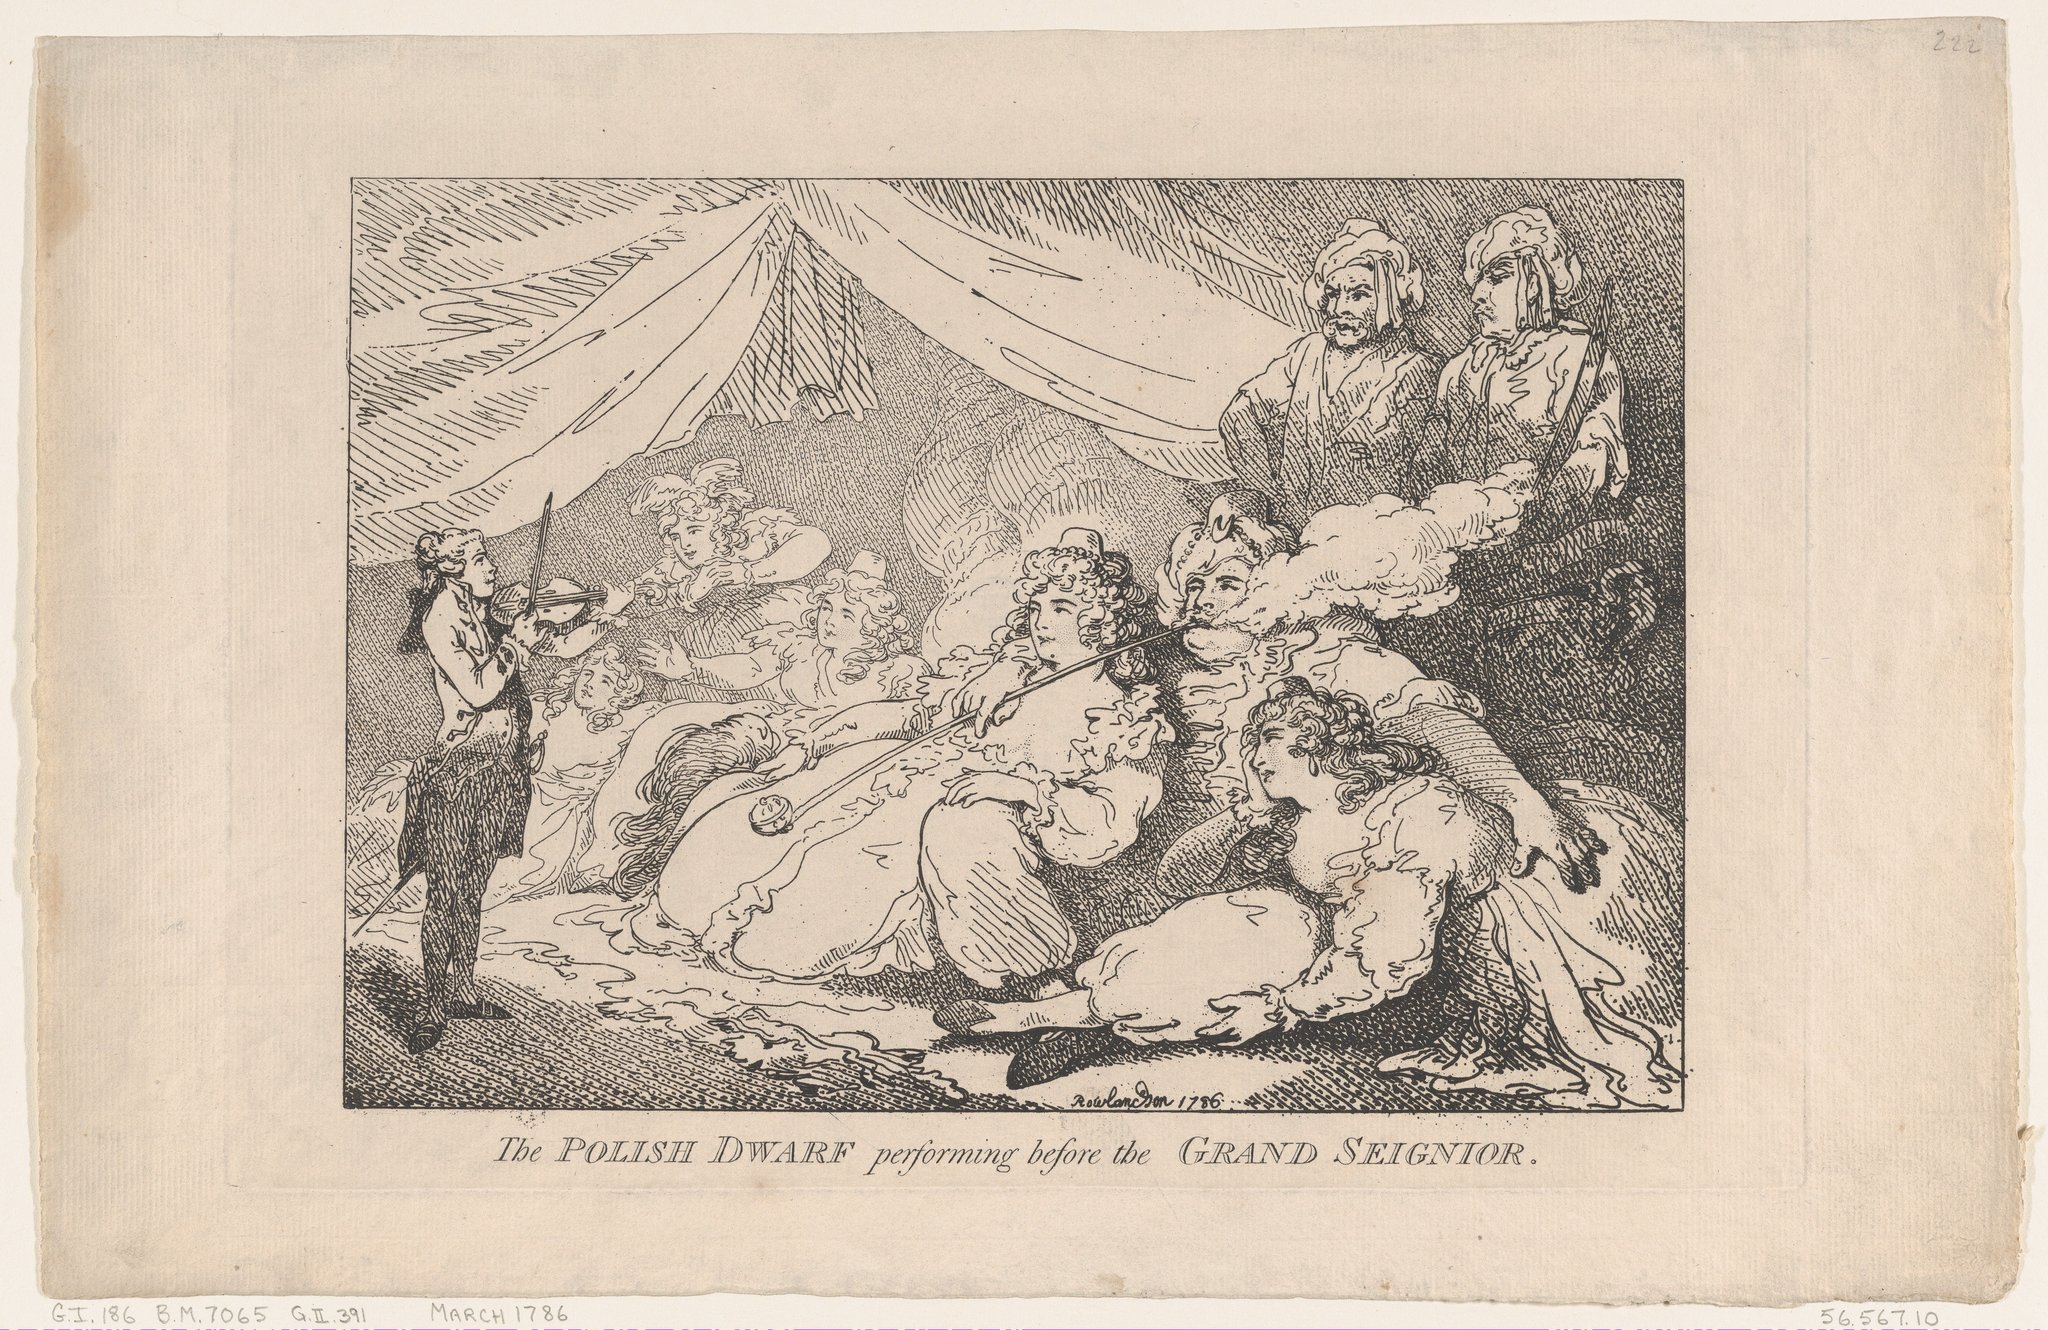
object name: print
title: The Polish Dwarf Performing Before the Grand Seignior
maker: thomas rowlandson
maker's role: artist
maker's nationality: british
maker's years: 1757-1827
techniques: etching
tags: men,women,musicians